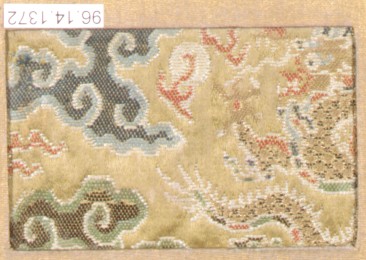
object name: piece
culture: chinese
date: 1701-1900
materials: silk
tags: dragons